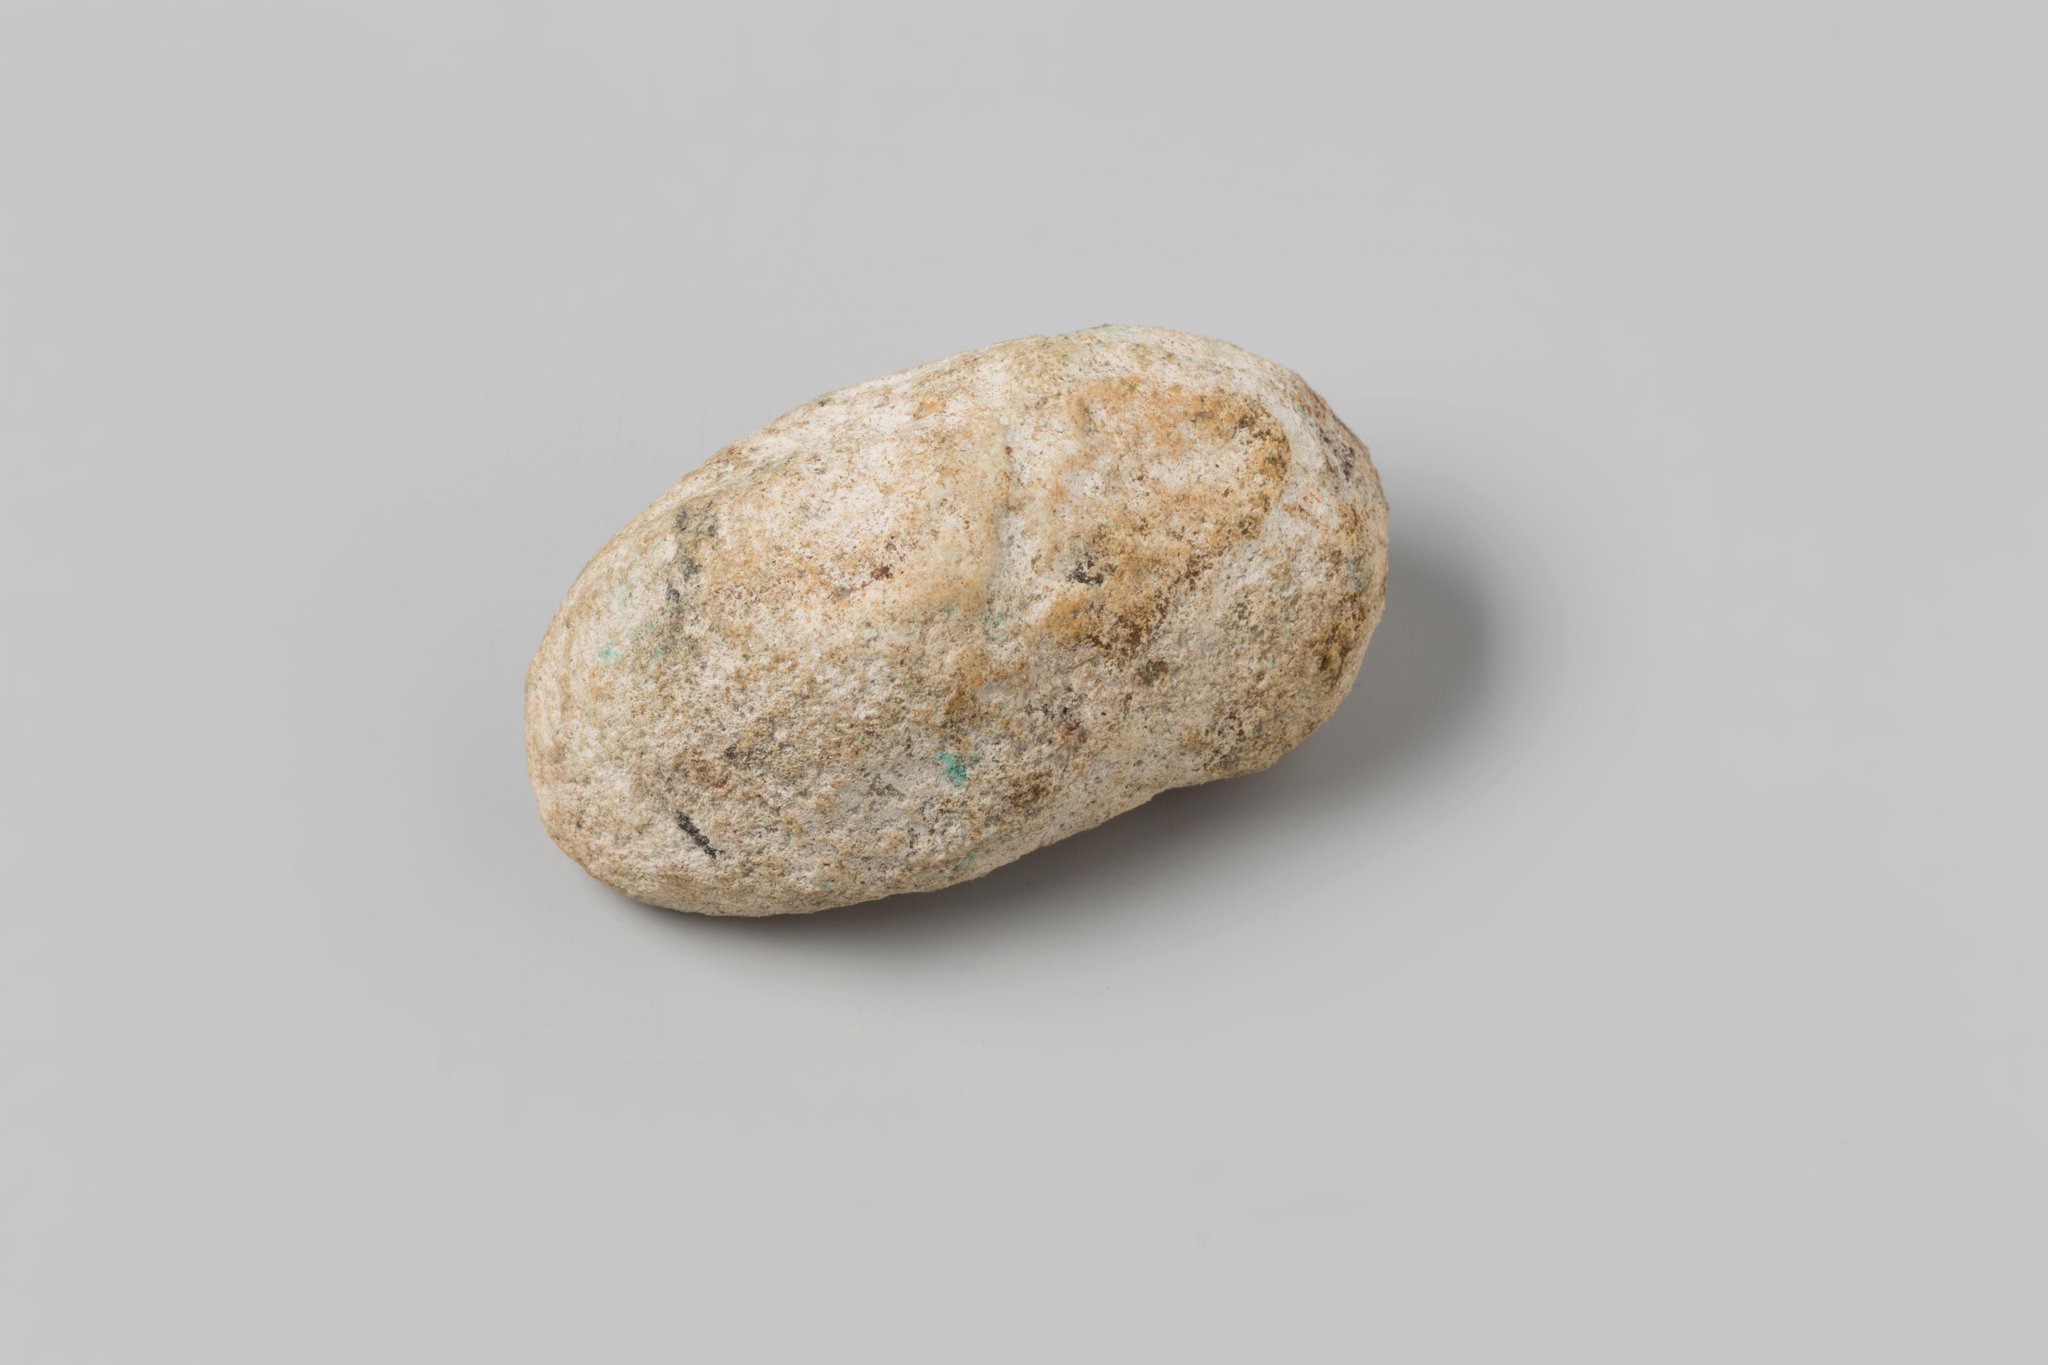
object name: scheepswrakvondst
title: Fragment zandsteen uit het wrak van de Oost-Indiëvaarder Hollandia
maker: Anonymous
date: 1700-1743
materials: stone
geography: netherlands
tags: verenigde oostindische compagnie, hollandia (schip), annet